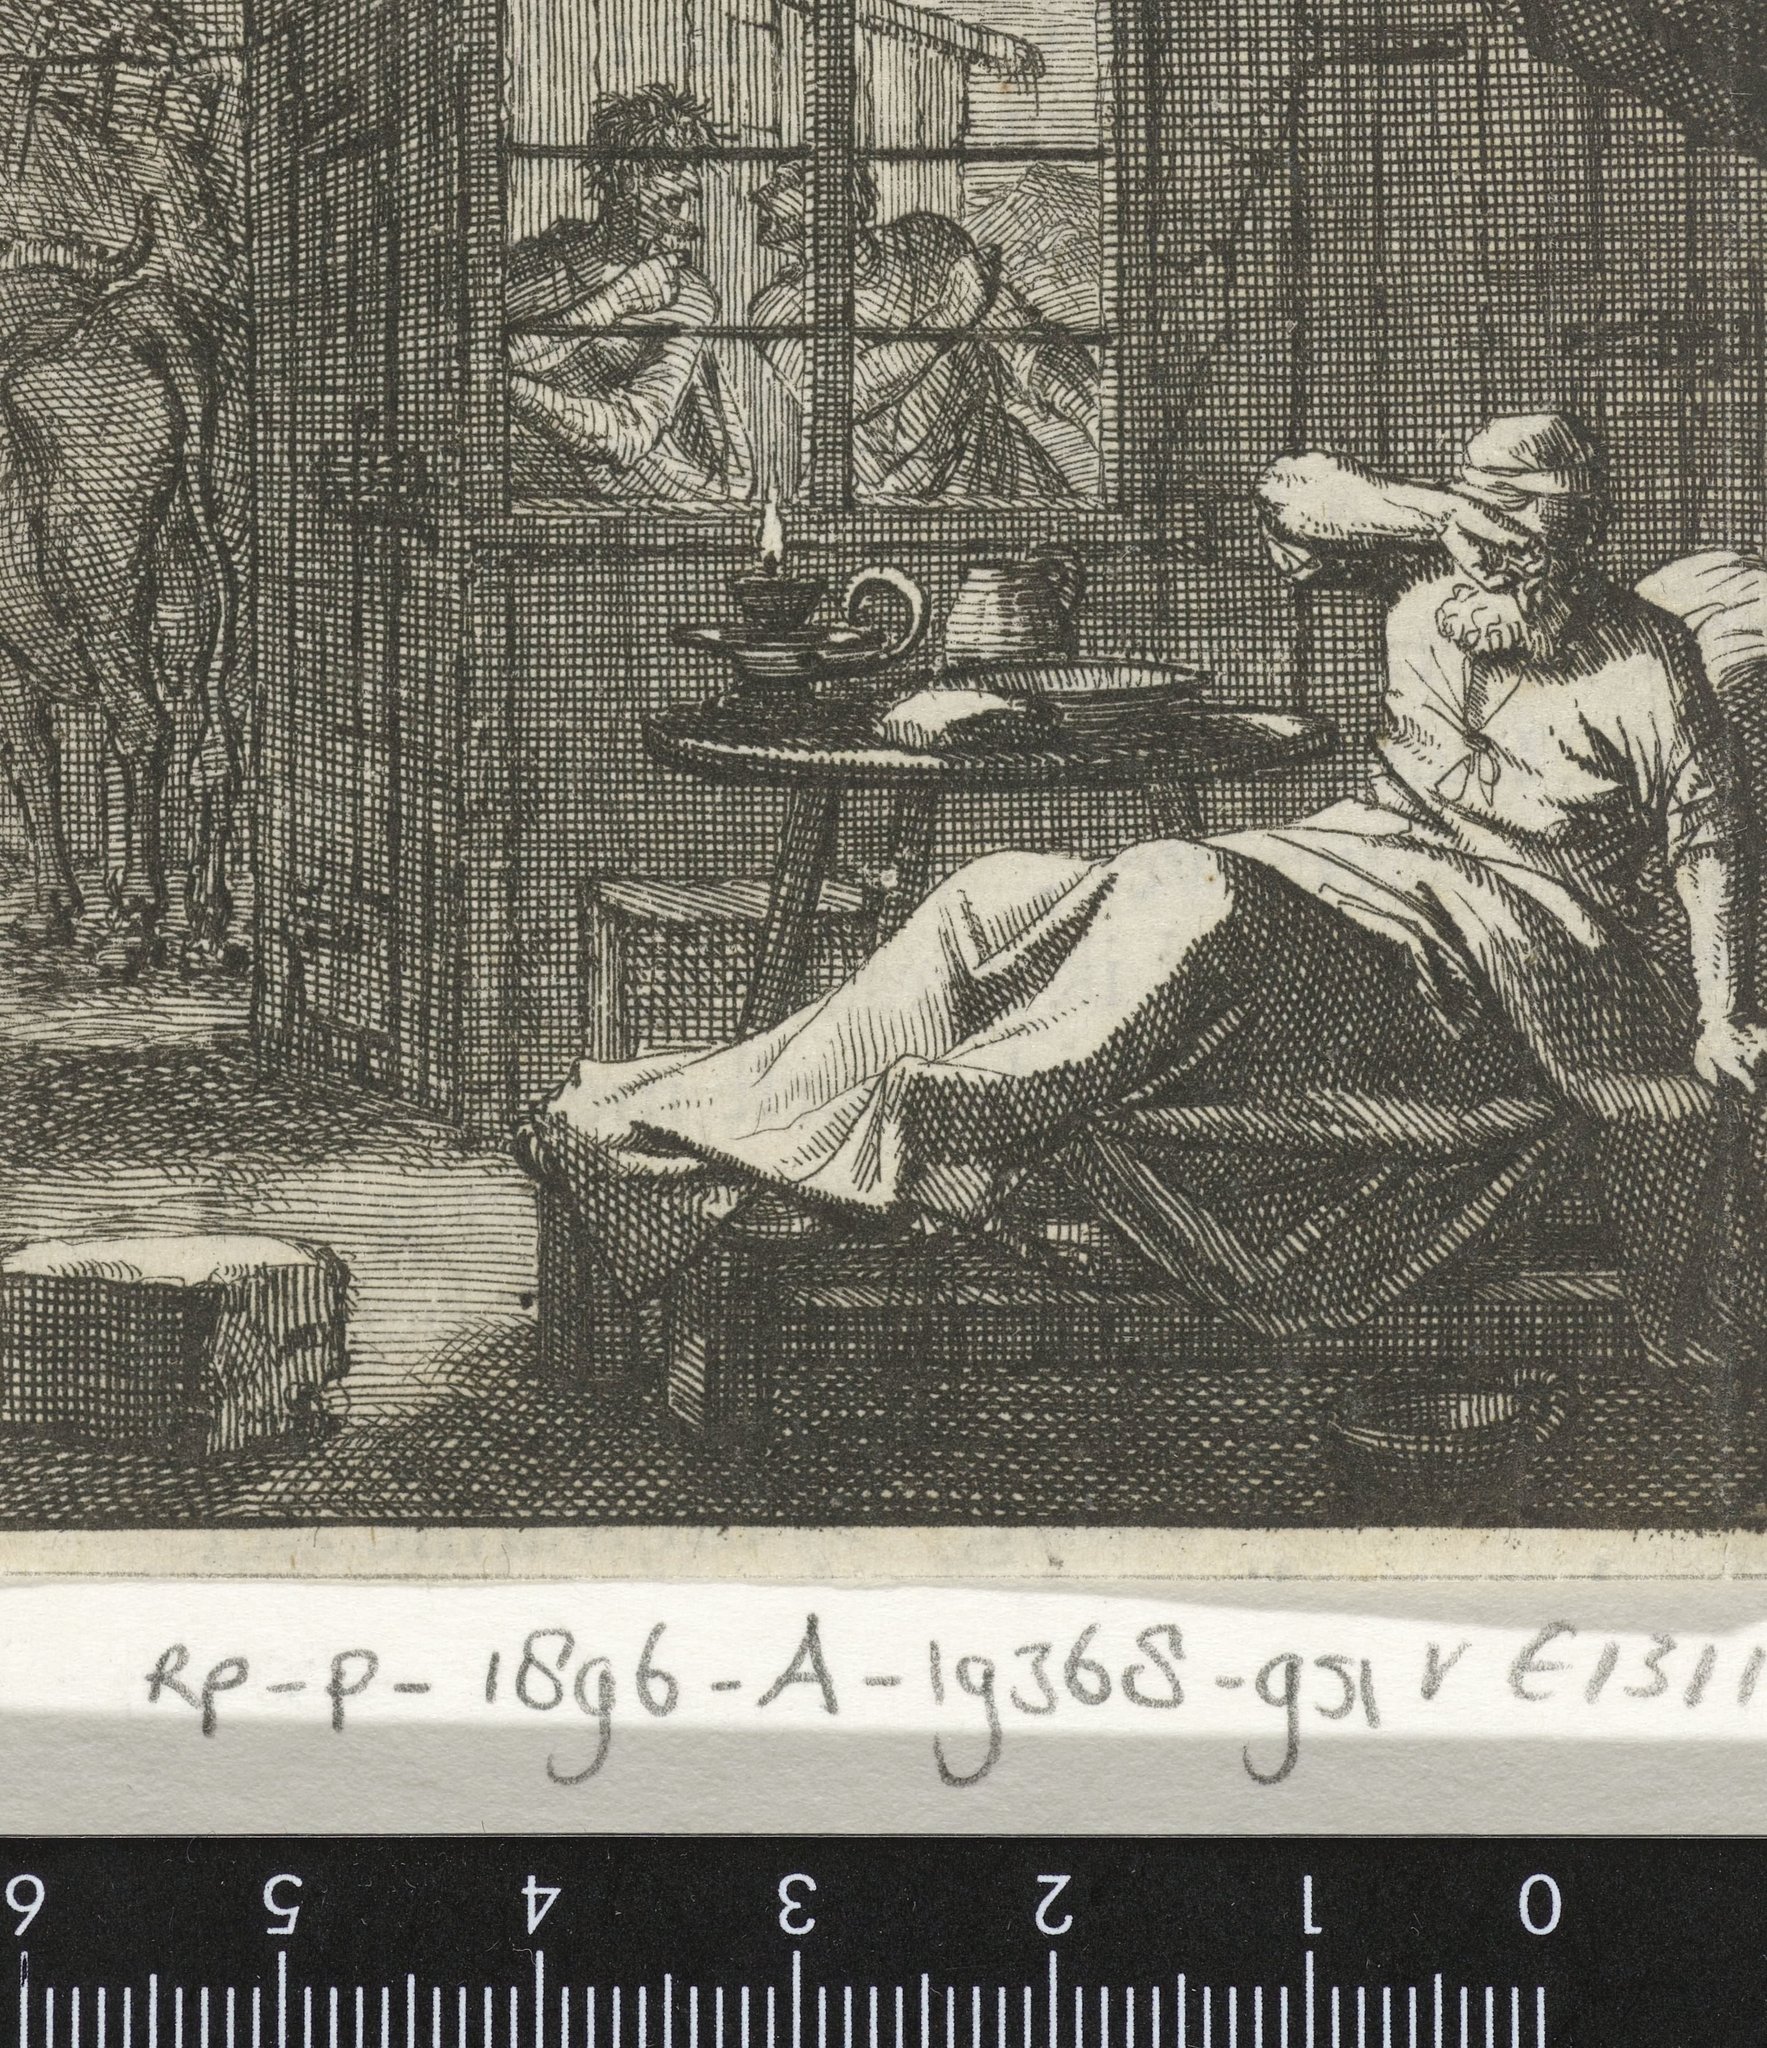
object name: print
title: Man bespeurt door het venster twee dieven die zich gereedmaken een koe te stelen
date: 1693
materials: paper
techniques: etching, letterpress printing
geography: amsterdam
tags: barn, cow, robber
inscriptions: collector's mark: Lugt 2228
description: Illustratie uit: Duĳkerius, Johannes. Voorbeeldzels der oude wyzen. Waar in (...) de menschelijke hartstogten (...) behandeld worden. Amsterdam: Aart Wolsgrein, 1693, p. 302.